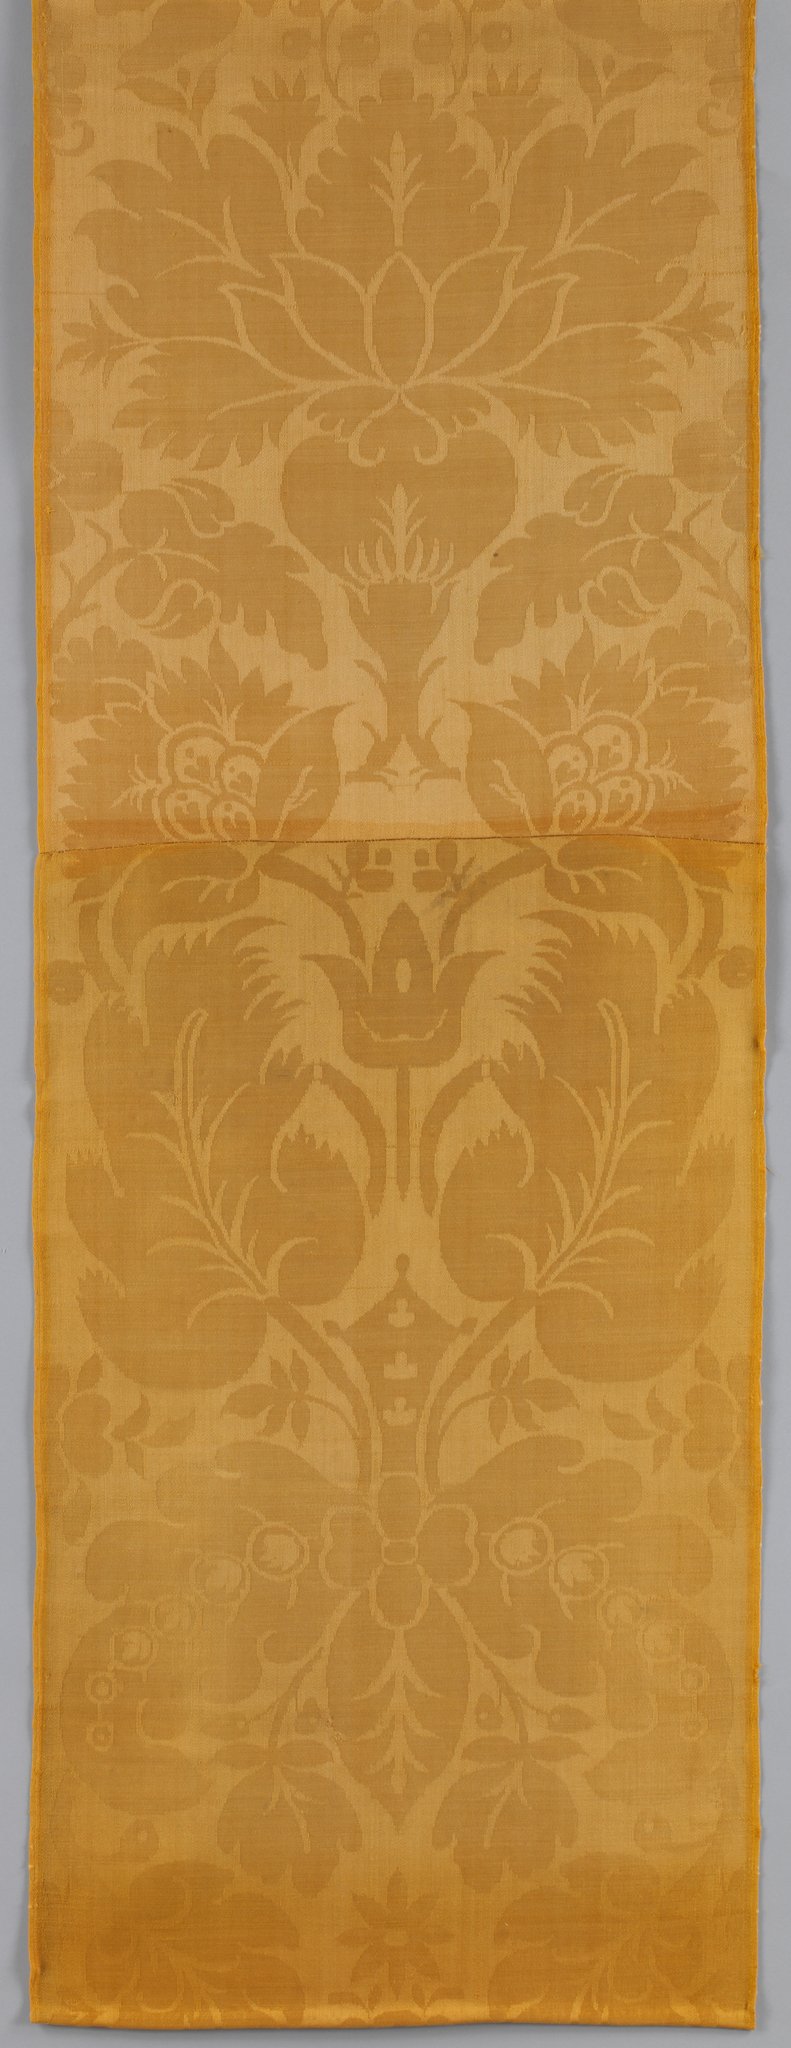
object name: piece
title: Length of wool damask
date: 1720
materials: wool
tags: flowers